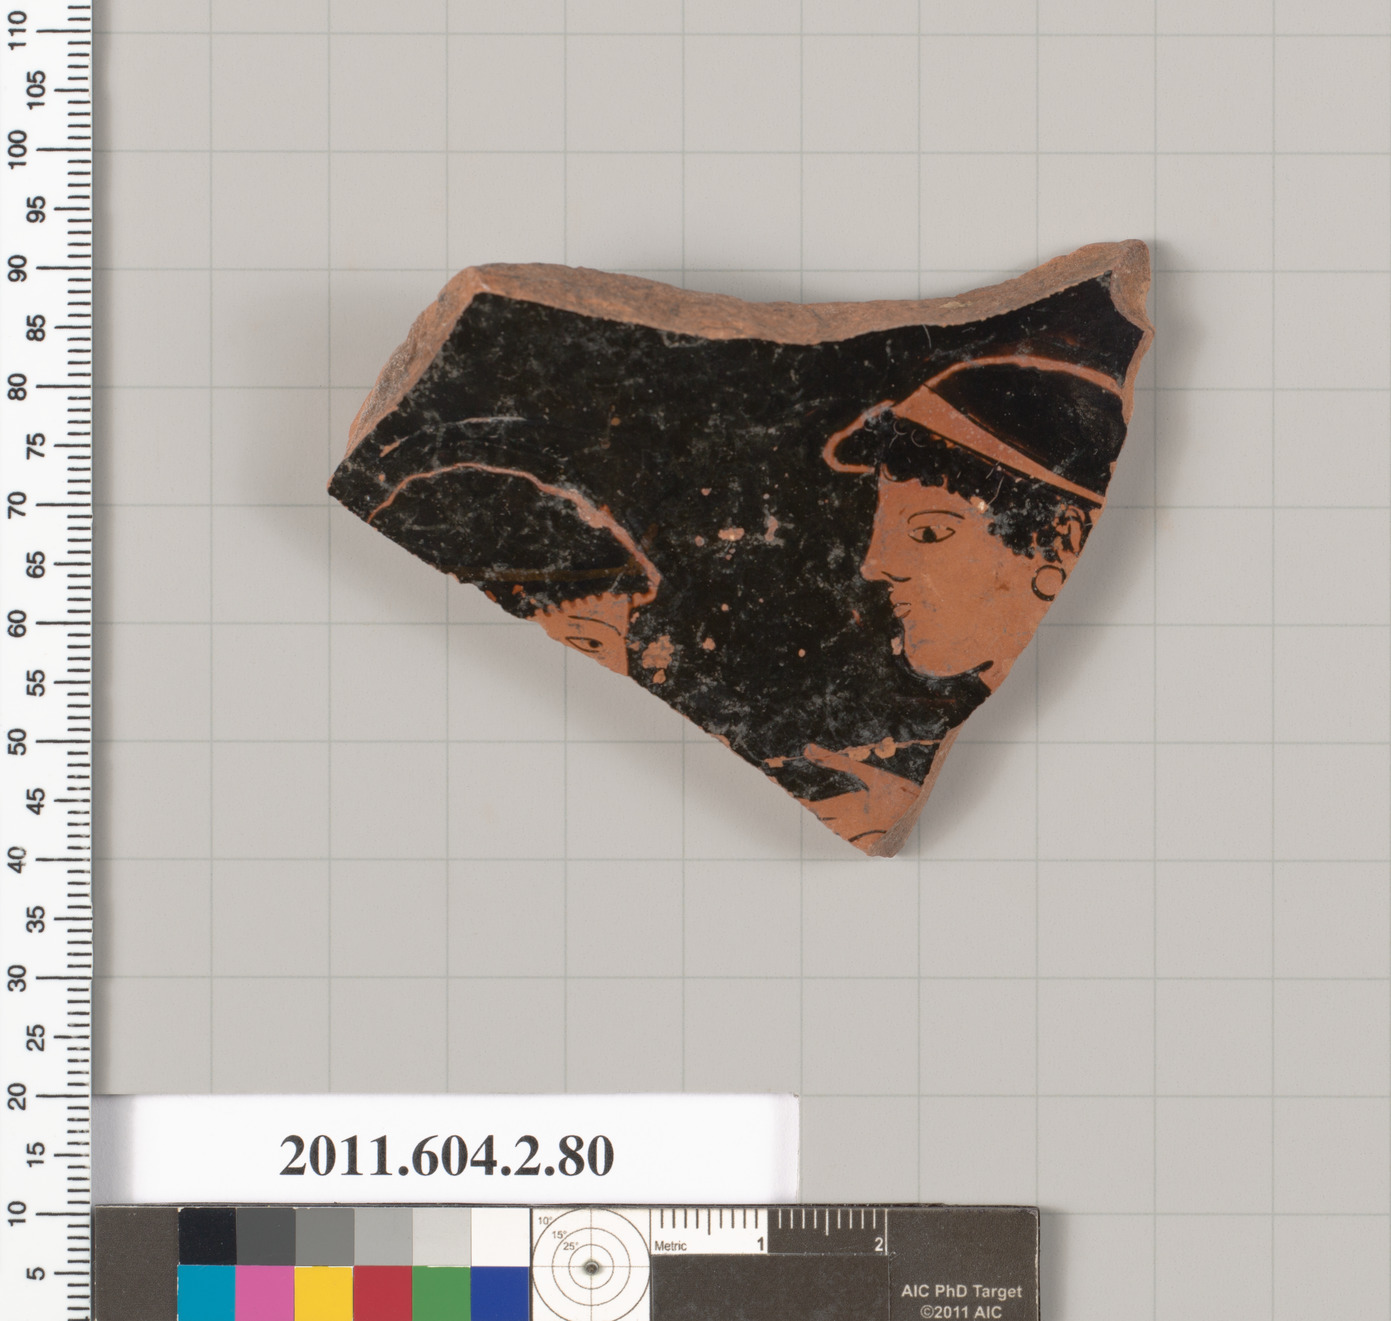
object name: pelike fragment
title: Terracotta fragment of a pelike (jar)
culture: greek, attic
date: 510-490 BCE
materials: terracotta